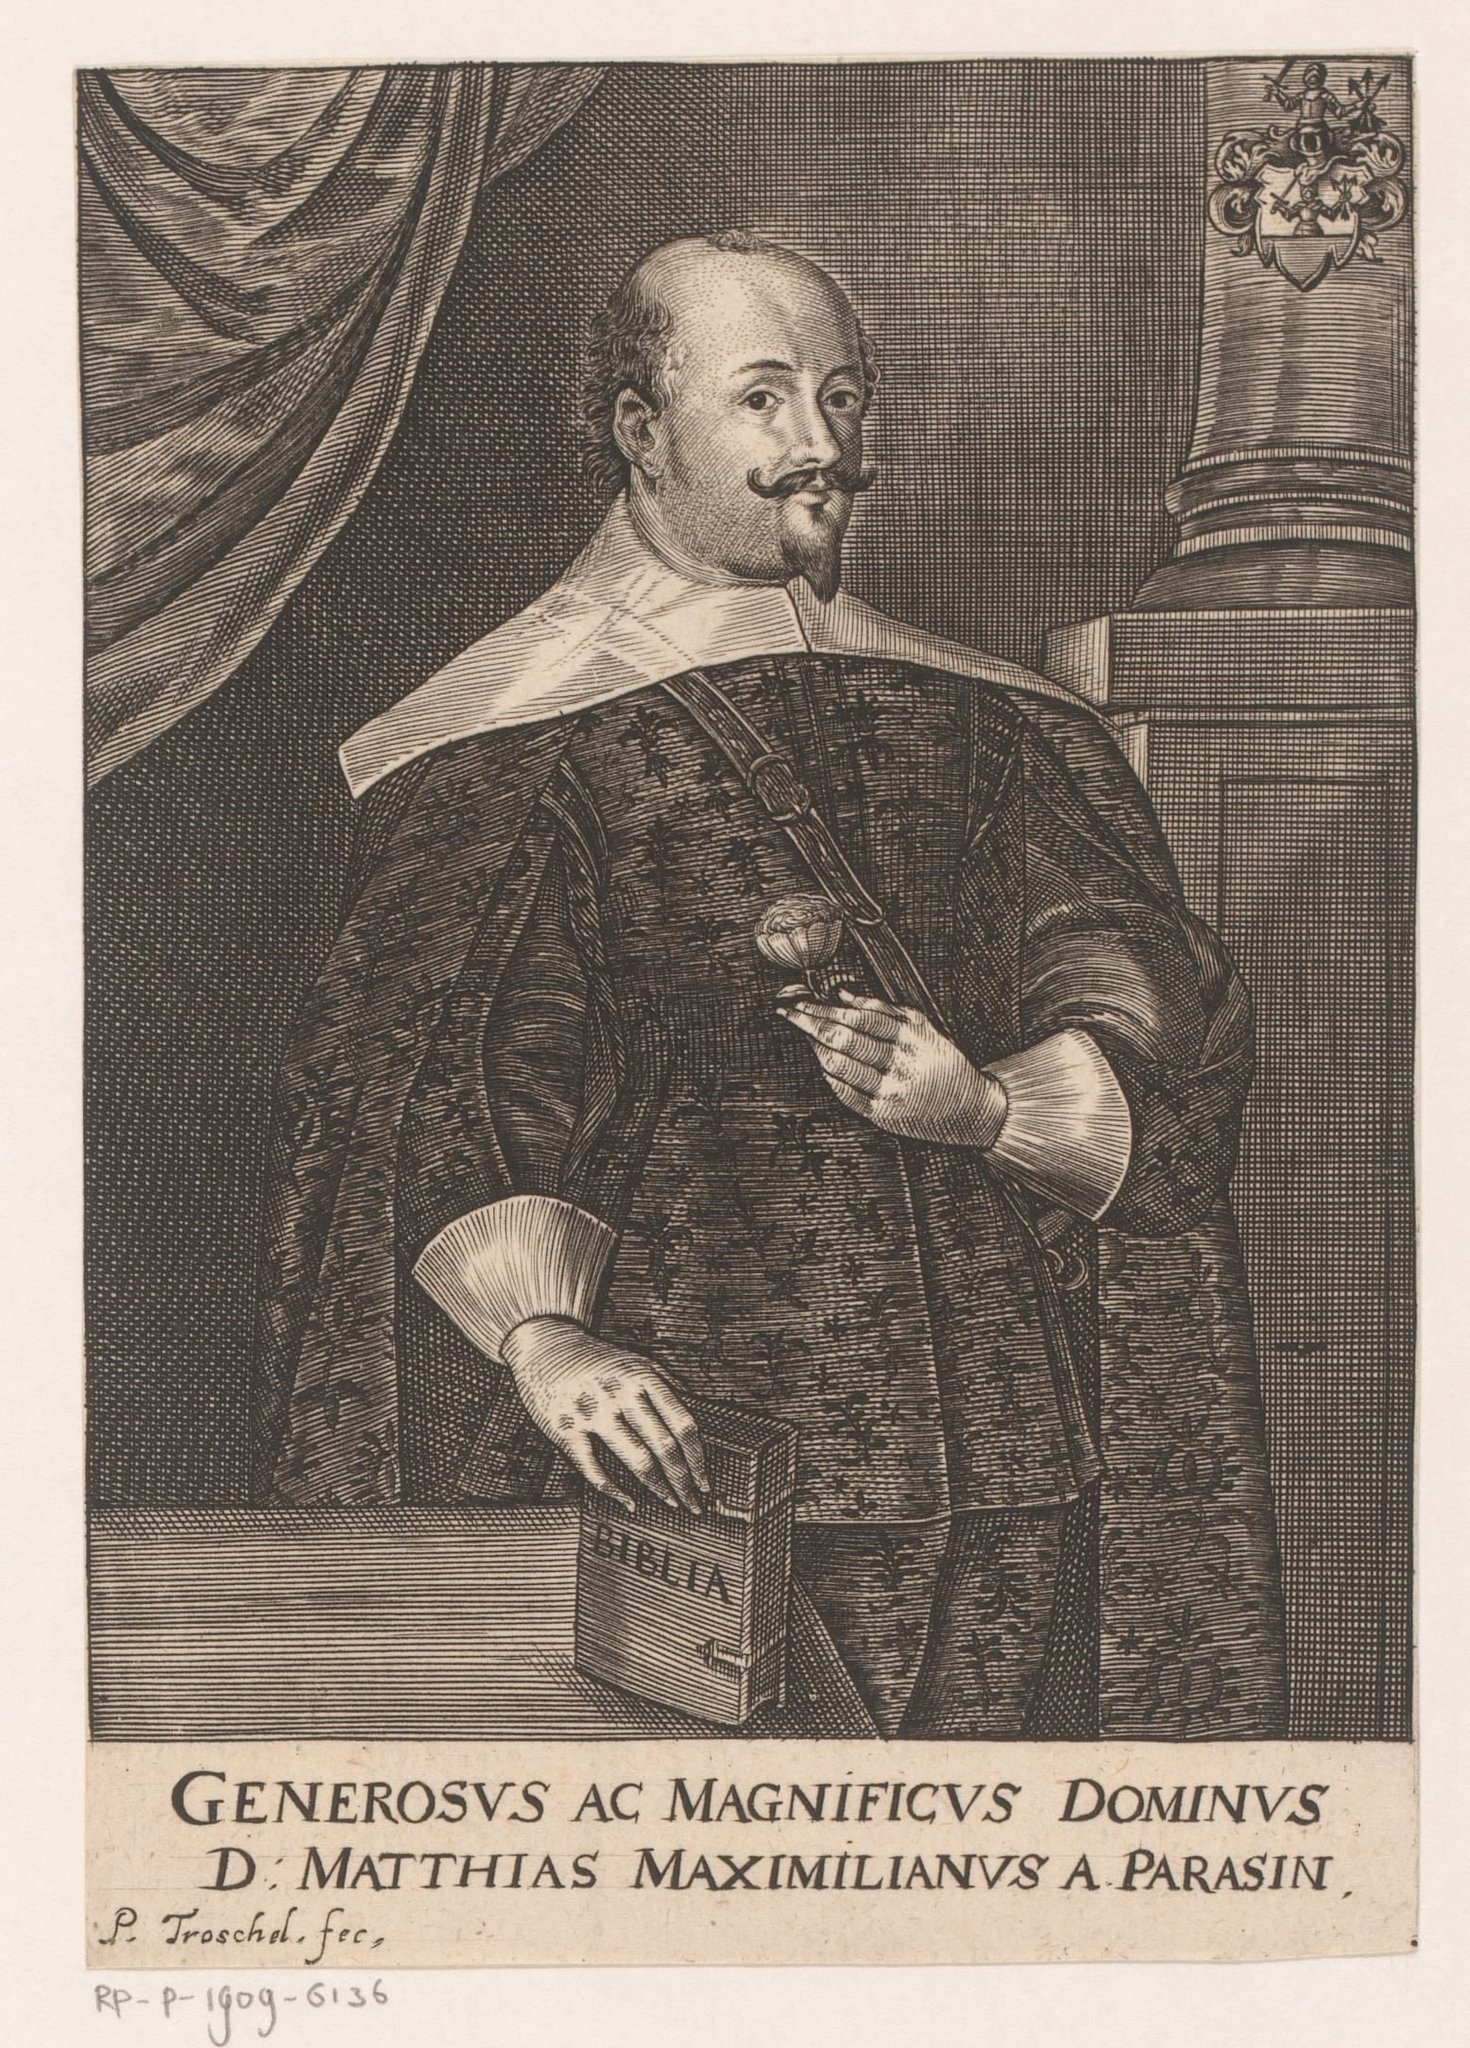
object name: print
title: Portret van Matthias Maximilian von Parasin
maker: peter troschel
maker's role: draughtsman, print maker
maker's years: 1620-1670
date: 1638-1670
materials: paper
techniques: engraving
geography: germany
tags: flowers, historical persons, armorial bearing, heraldry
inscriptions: collector's mark: Lugt 2228